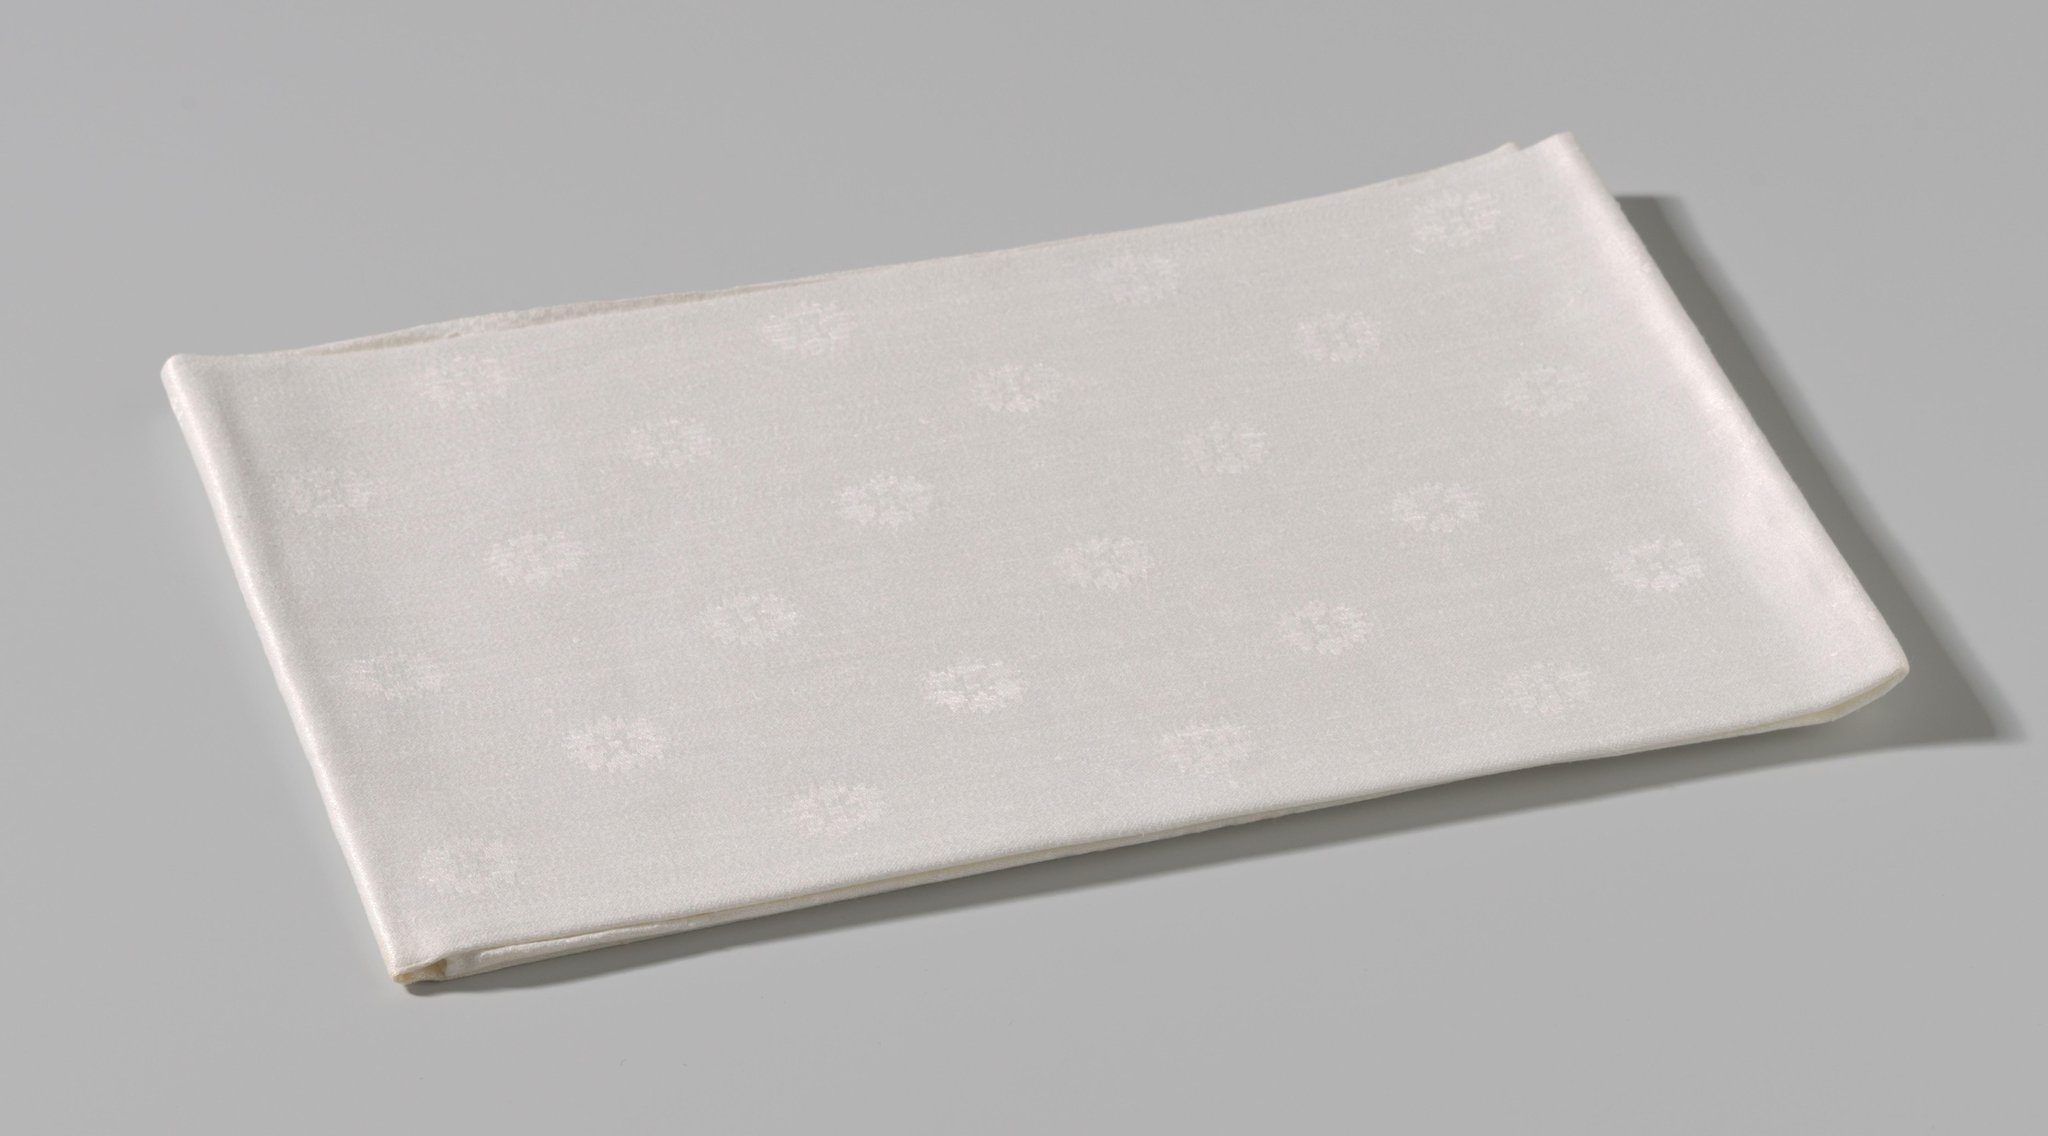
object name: napkin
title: Servet met een bloempatroon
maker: Anonymous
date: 1800-1810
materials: linen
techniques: damask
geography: western europe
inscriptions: mark: ‘ME’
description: Servet van linnendamast met een bloempatroon. Verspringende rijen van rozetten. Brede rand van spiraalsgewijs een middenstam omvattende tweezijdig gevederde bladranken. Vallend blaadje als vulling. Gelijke binnen- en buitenzoom van aaneengeschakelde cirkels. Rondom: blokkenrand. De bladranken van de servetten zijn niet identiek aan die van het tafellaken.